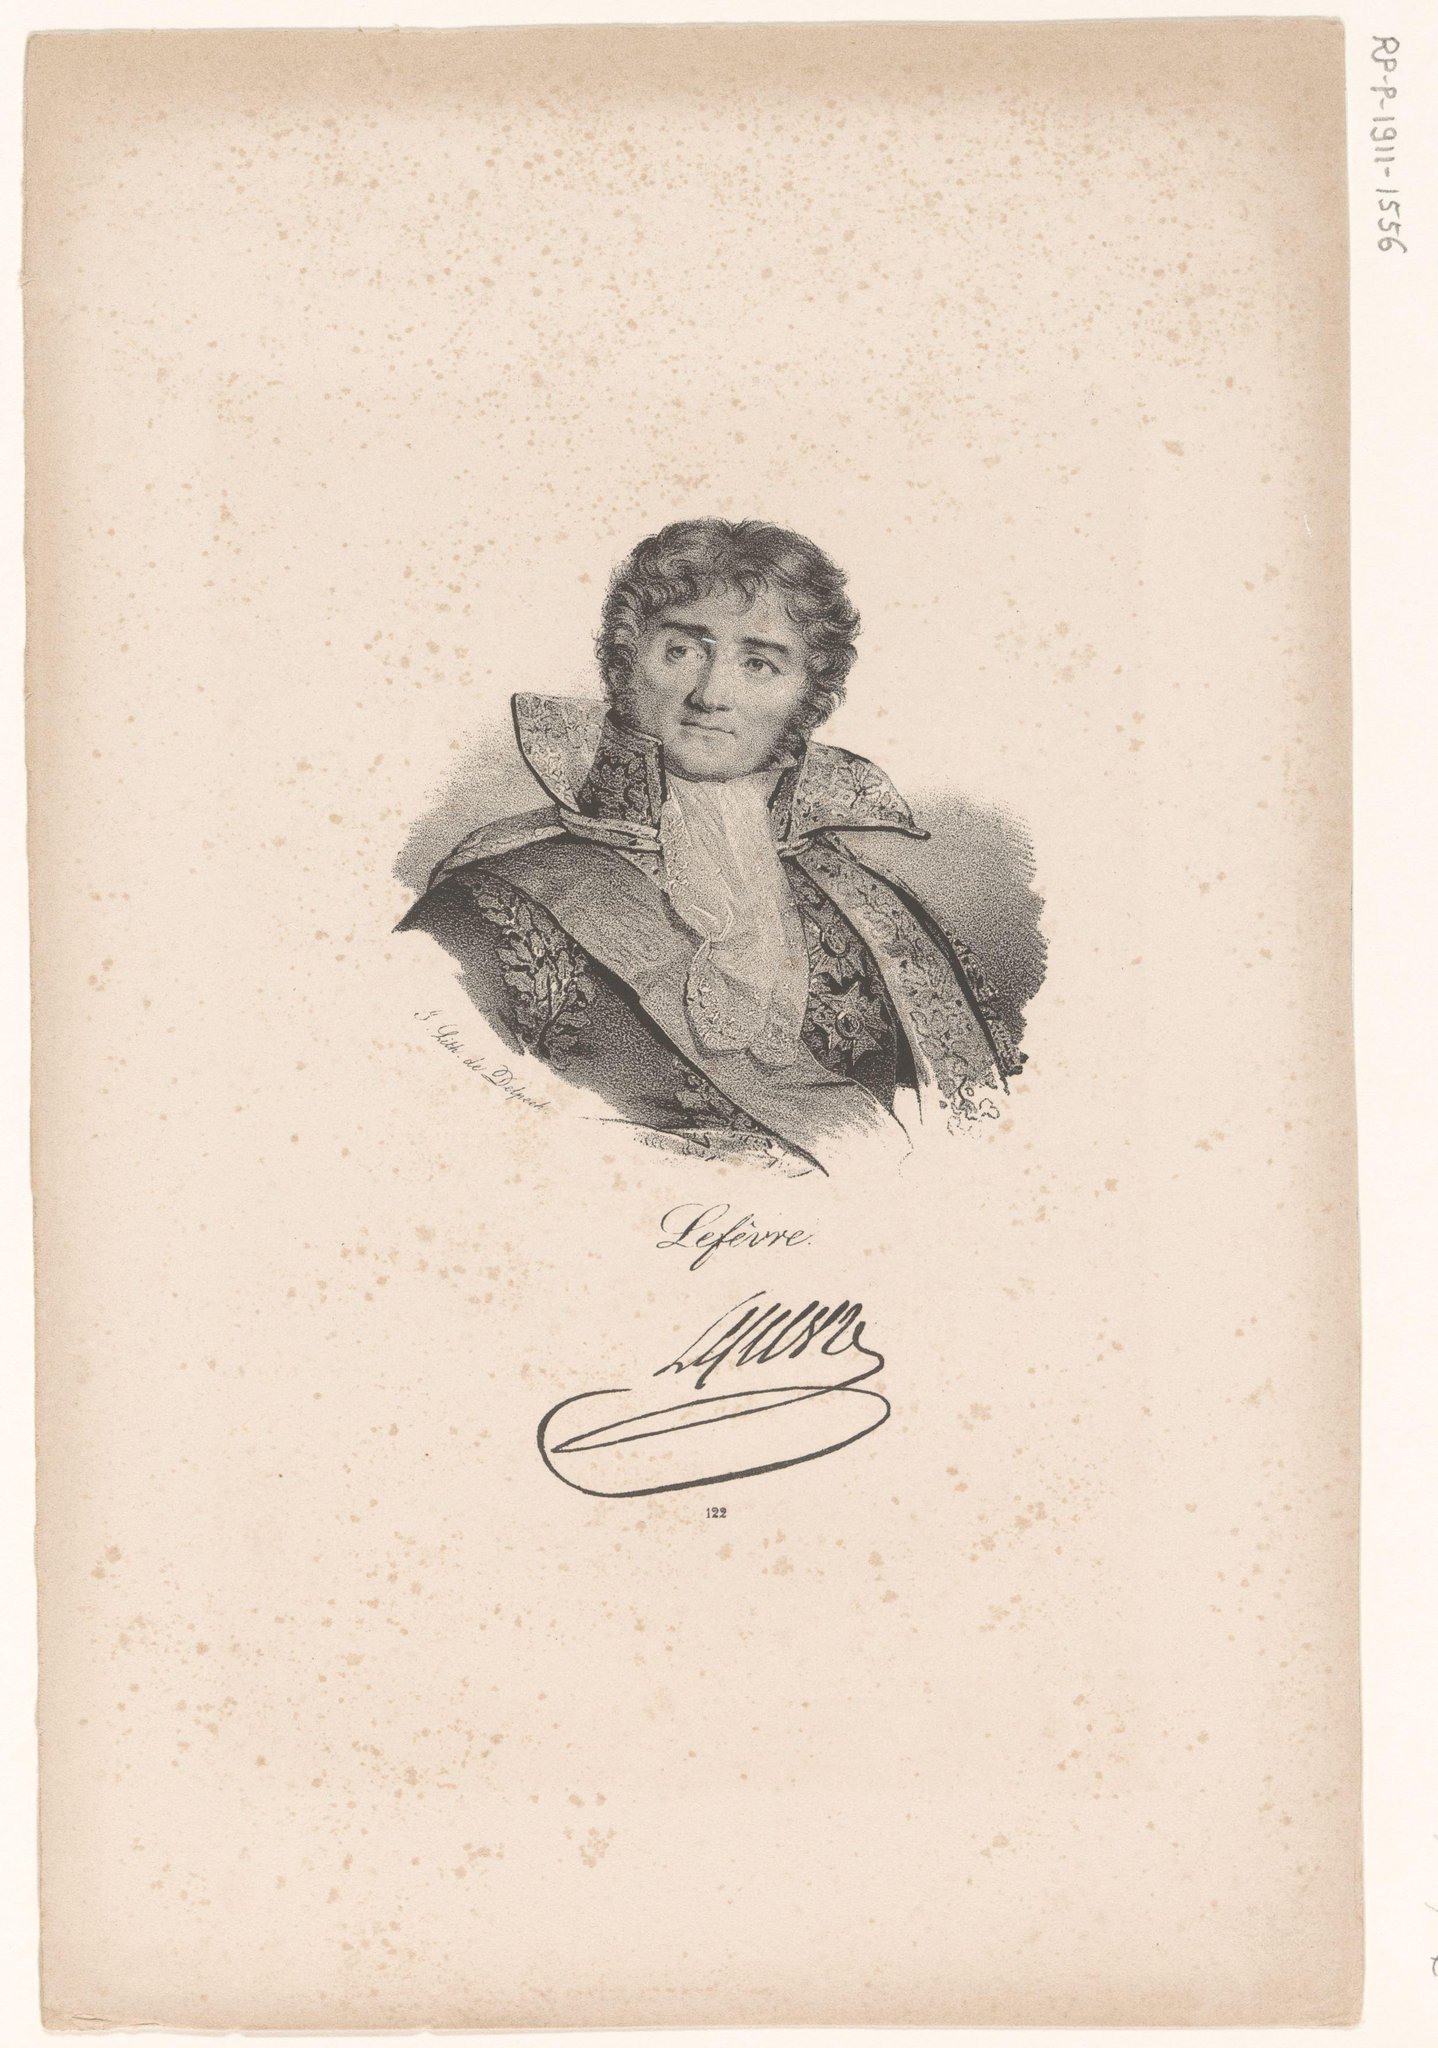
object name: print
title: Lefèvre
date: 1818-1842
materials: paper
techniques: lithograph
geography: paris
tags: historical persons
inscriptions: collector's mark: Lugt 2228a